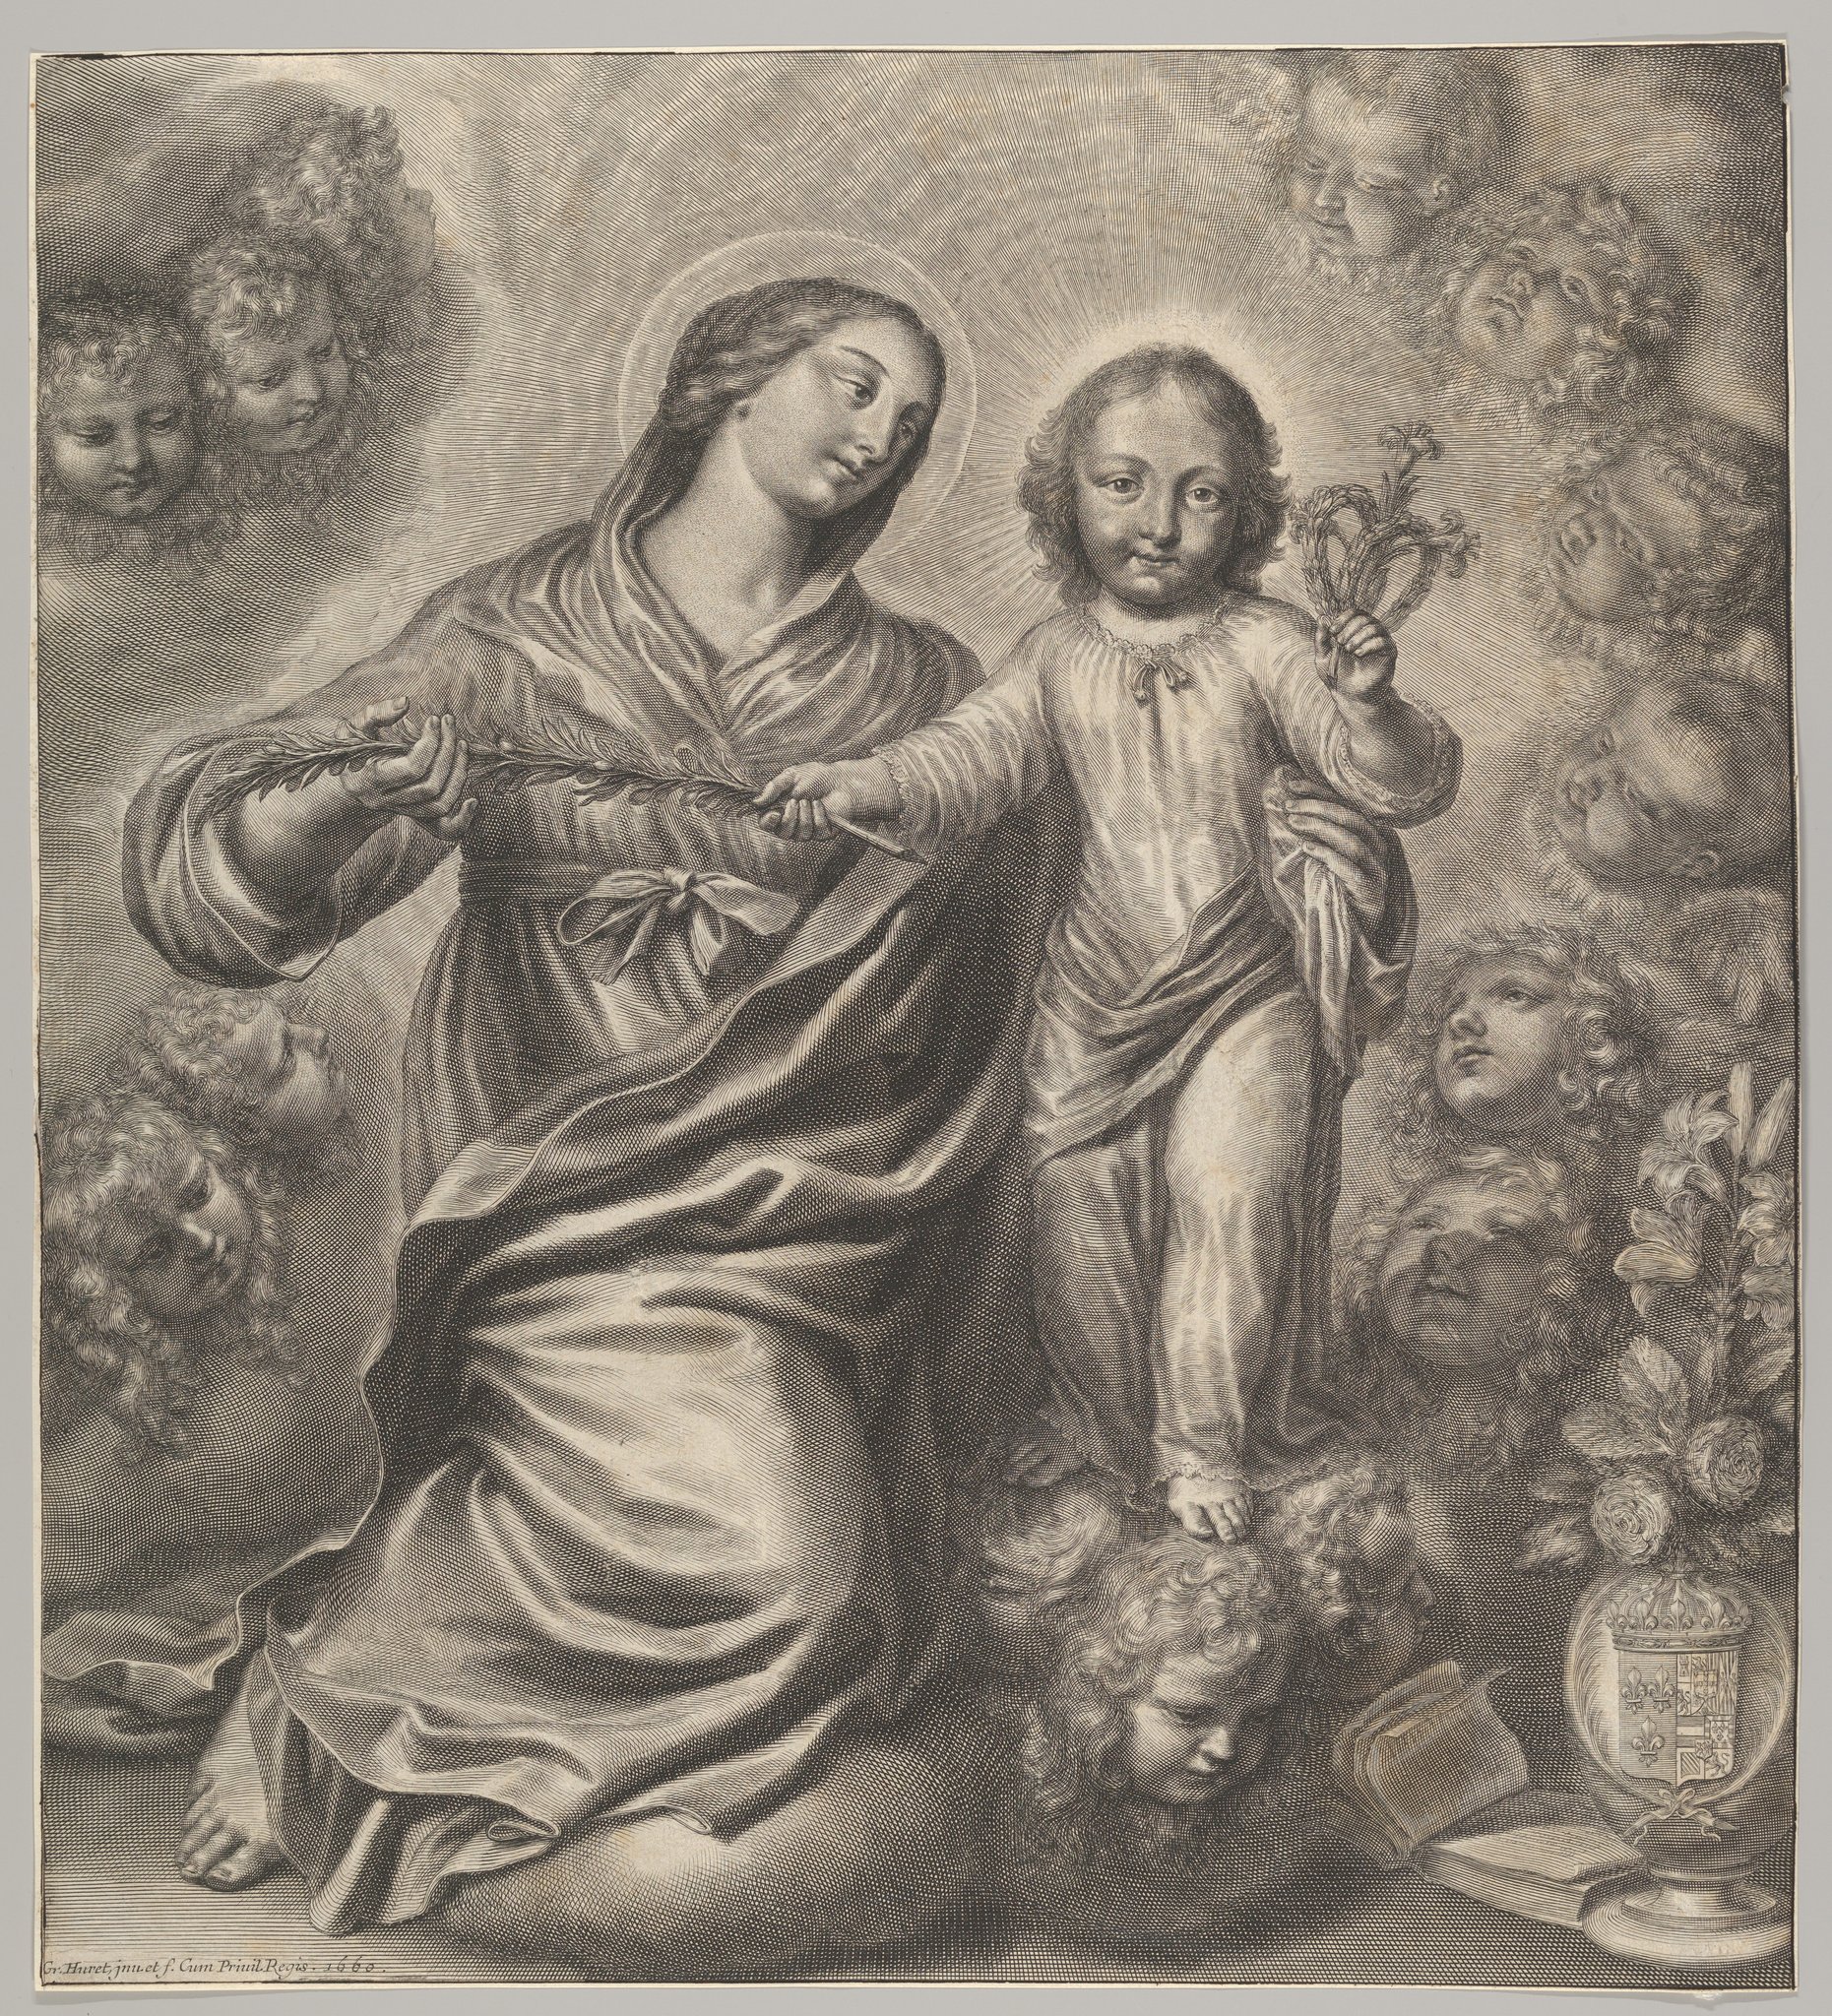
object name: print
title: Virgin and Child Surrounded by Cherubs' Heads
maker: grégoire huret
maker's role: artist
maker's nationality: french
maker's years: 1606-1670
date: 1660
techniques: engraving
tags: madonna and child,virgin mary,jesus